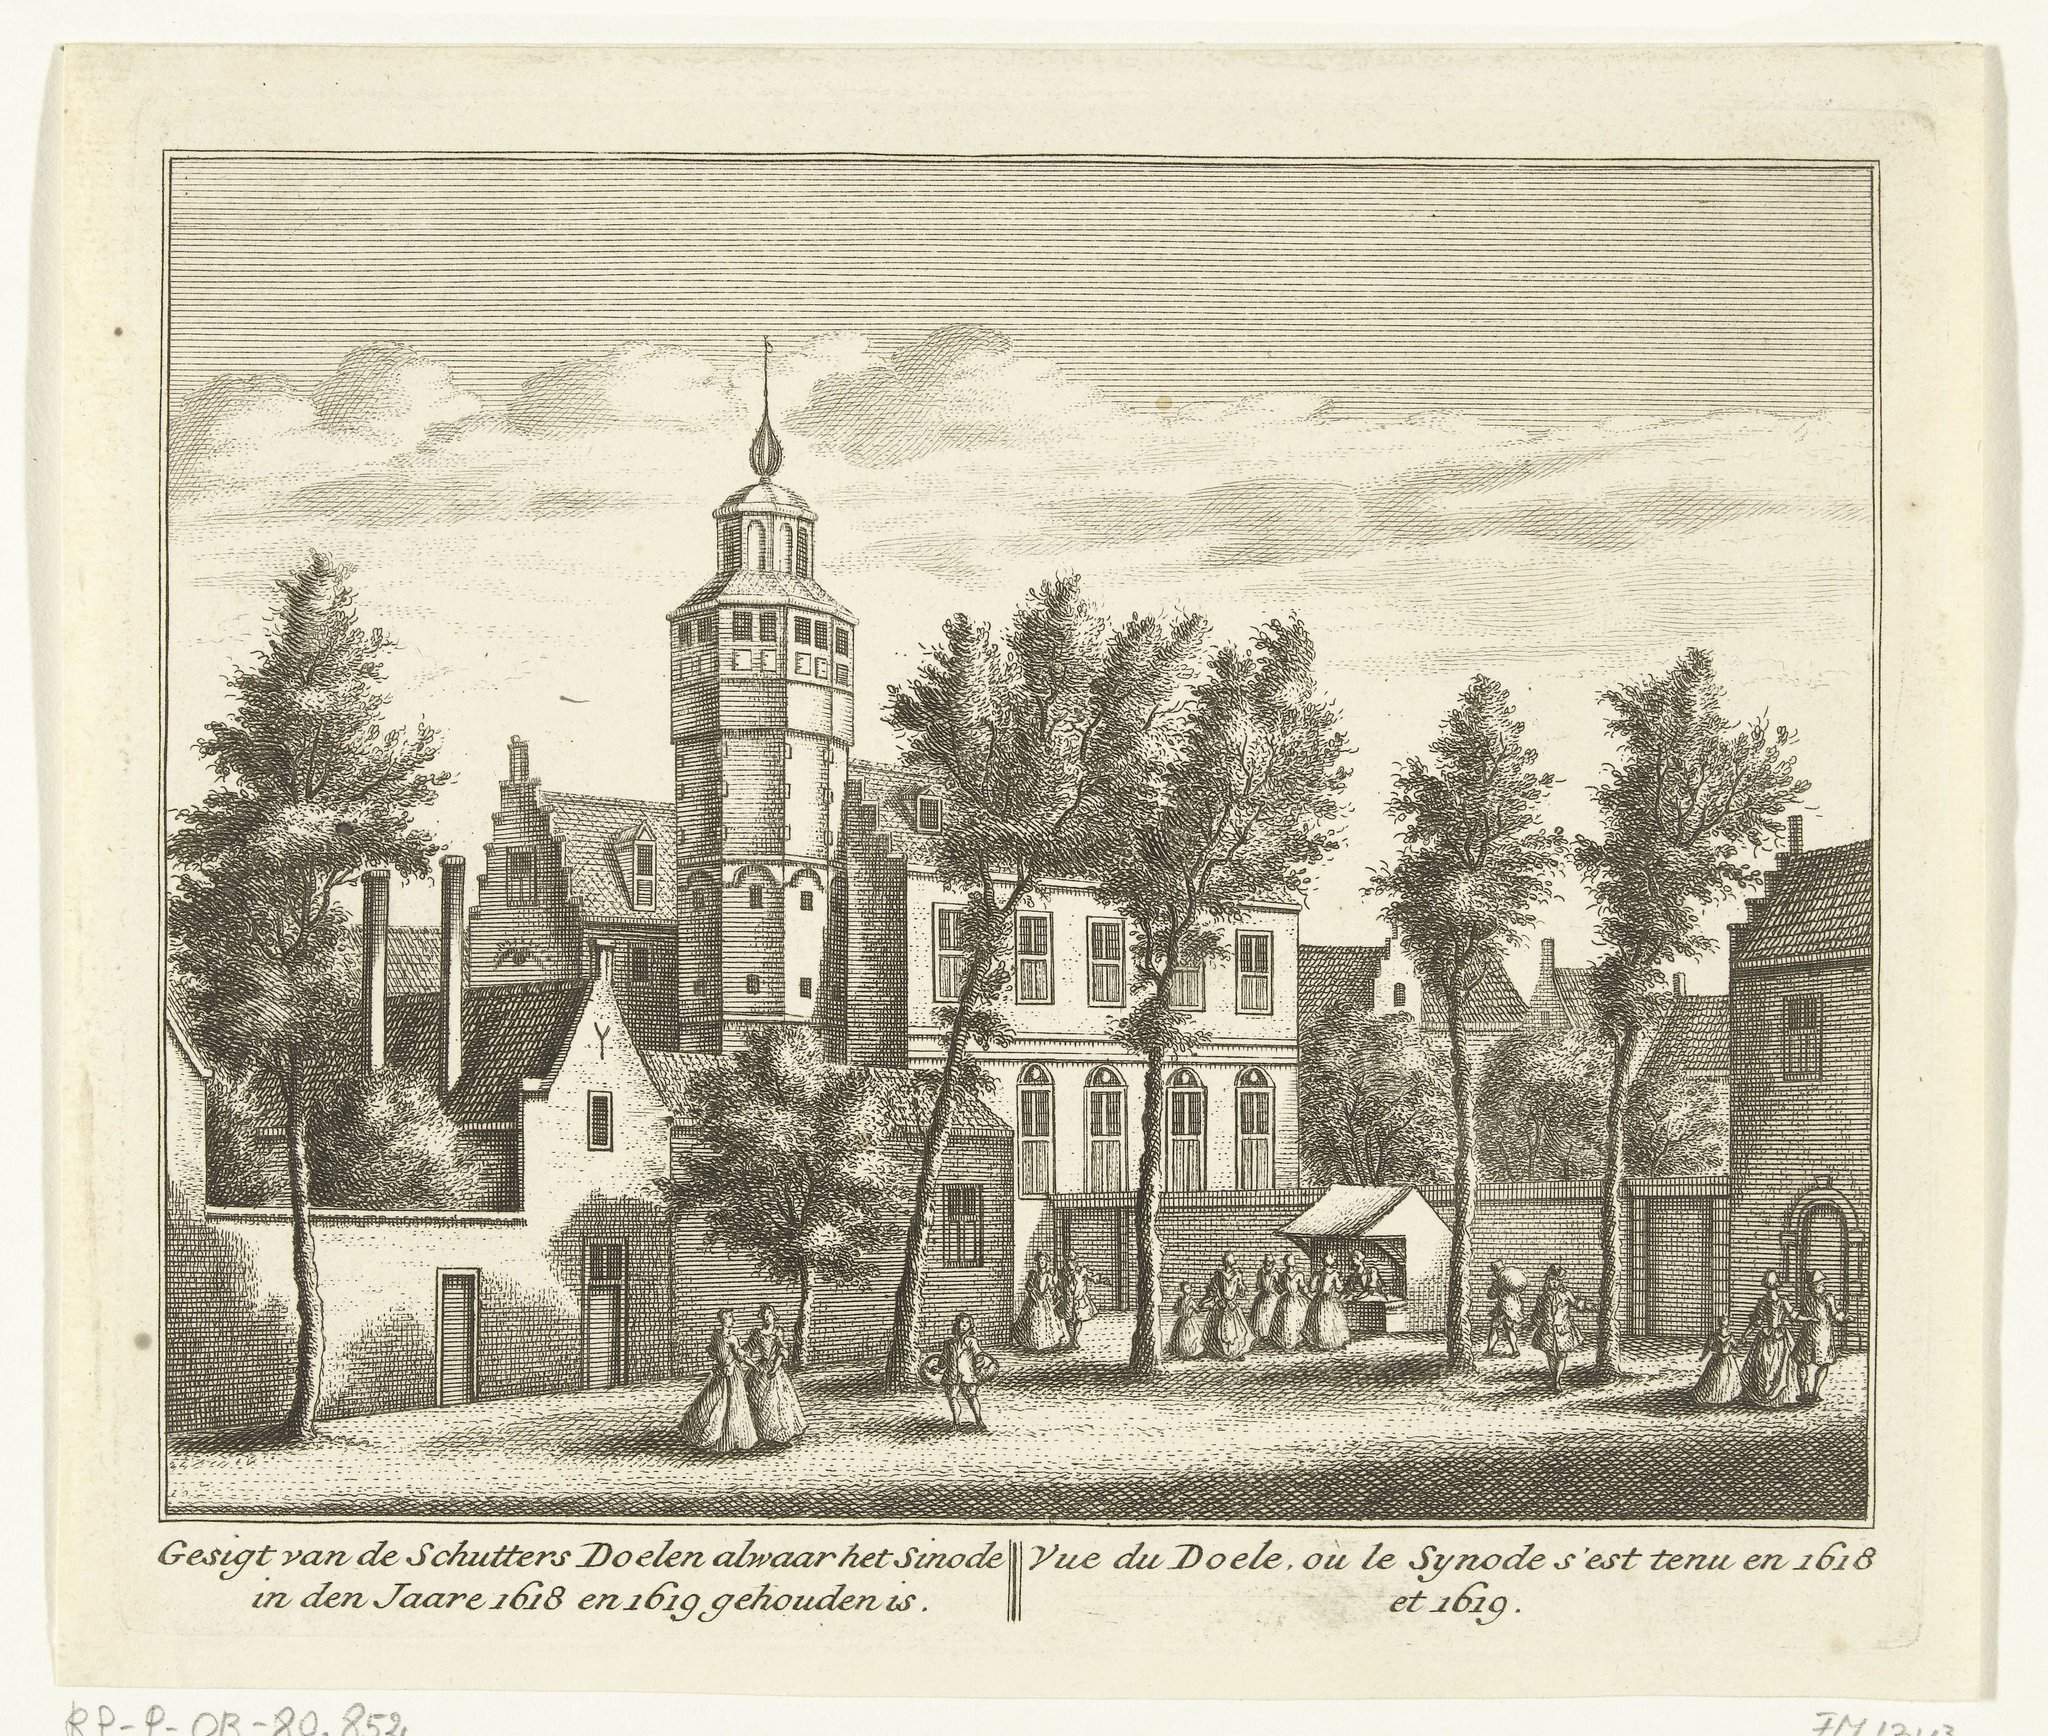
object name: history print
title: Gezicht op de Kloveniersdoelen te Dordrecht waar de Nationale Synode is gehouden in 1618-1619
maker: leonard schenk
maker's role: print maker, publisher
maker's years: 1696-1767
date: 1736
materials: paper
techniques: engraving, etching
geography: amsterdam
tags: exterior ~ representation of a building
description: Prent ook gebruikt in: Rademaker, Abraham. Alle de voornaamste gesigten van de wydberoemde steeden Alkmaar, Delft en Dordregt (...) / Toutes les principales vuës de la fameuse villes d'Alcmar, Delft & Dordregt […]. Amsterdam: Leonard Schenk, 1736.